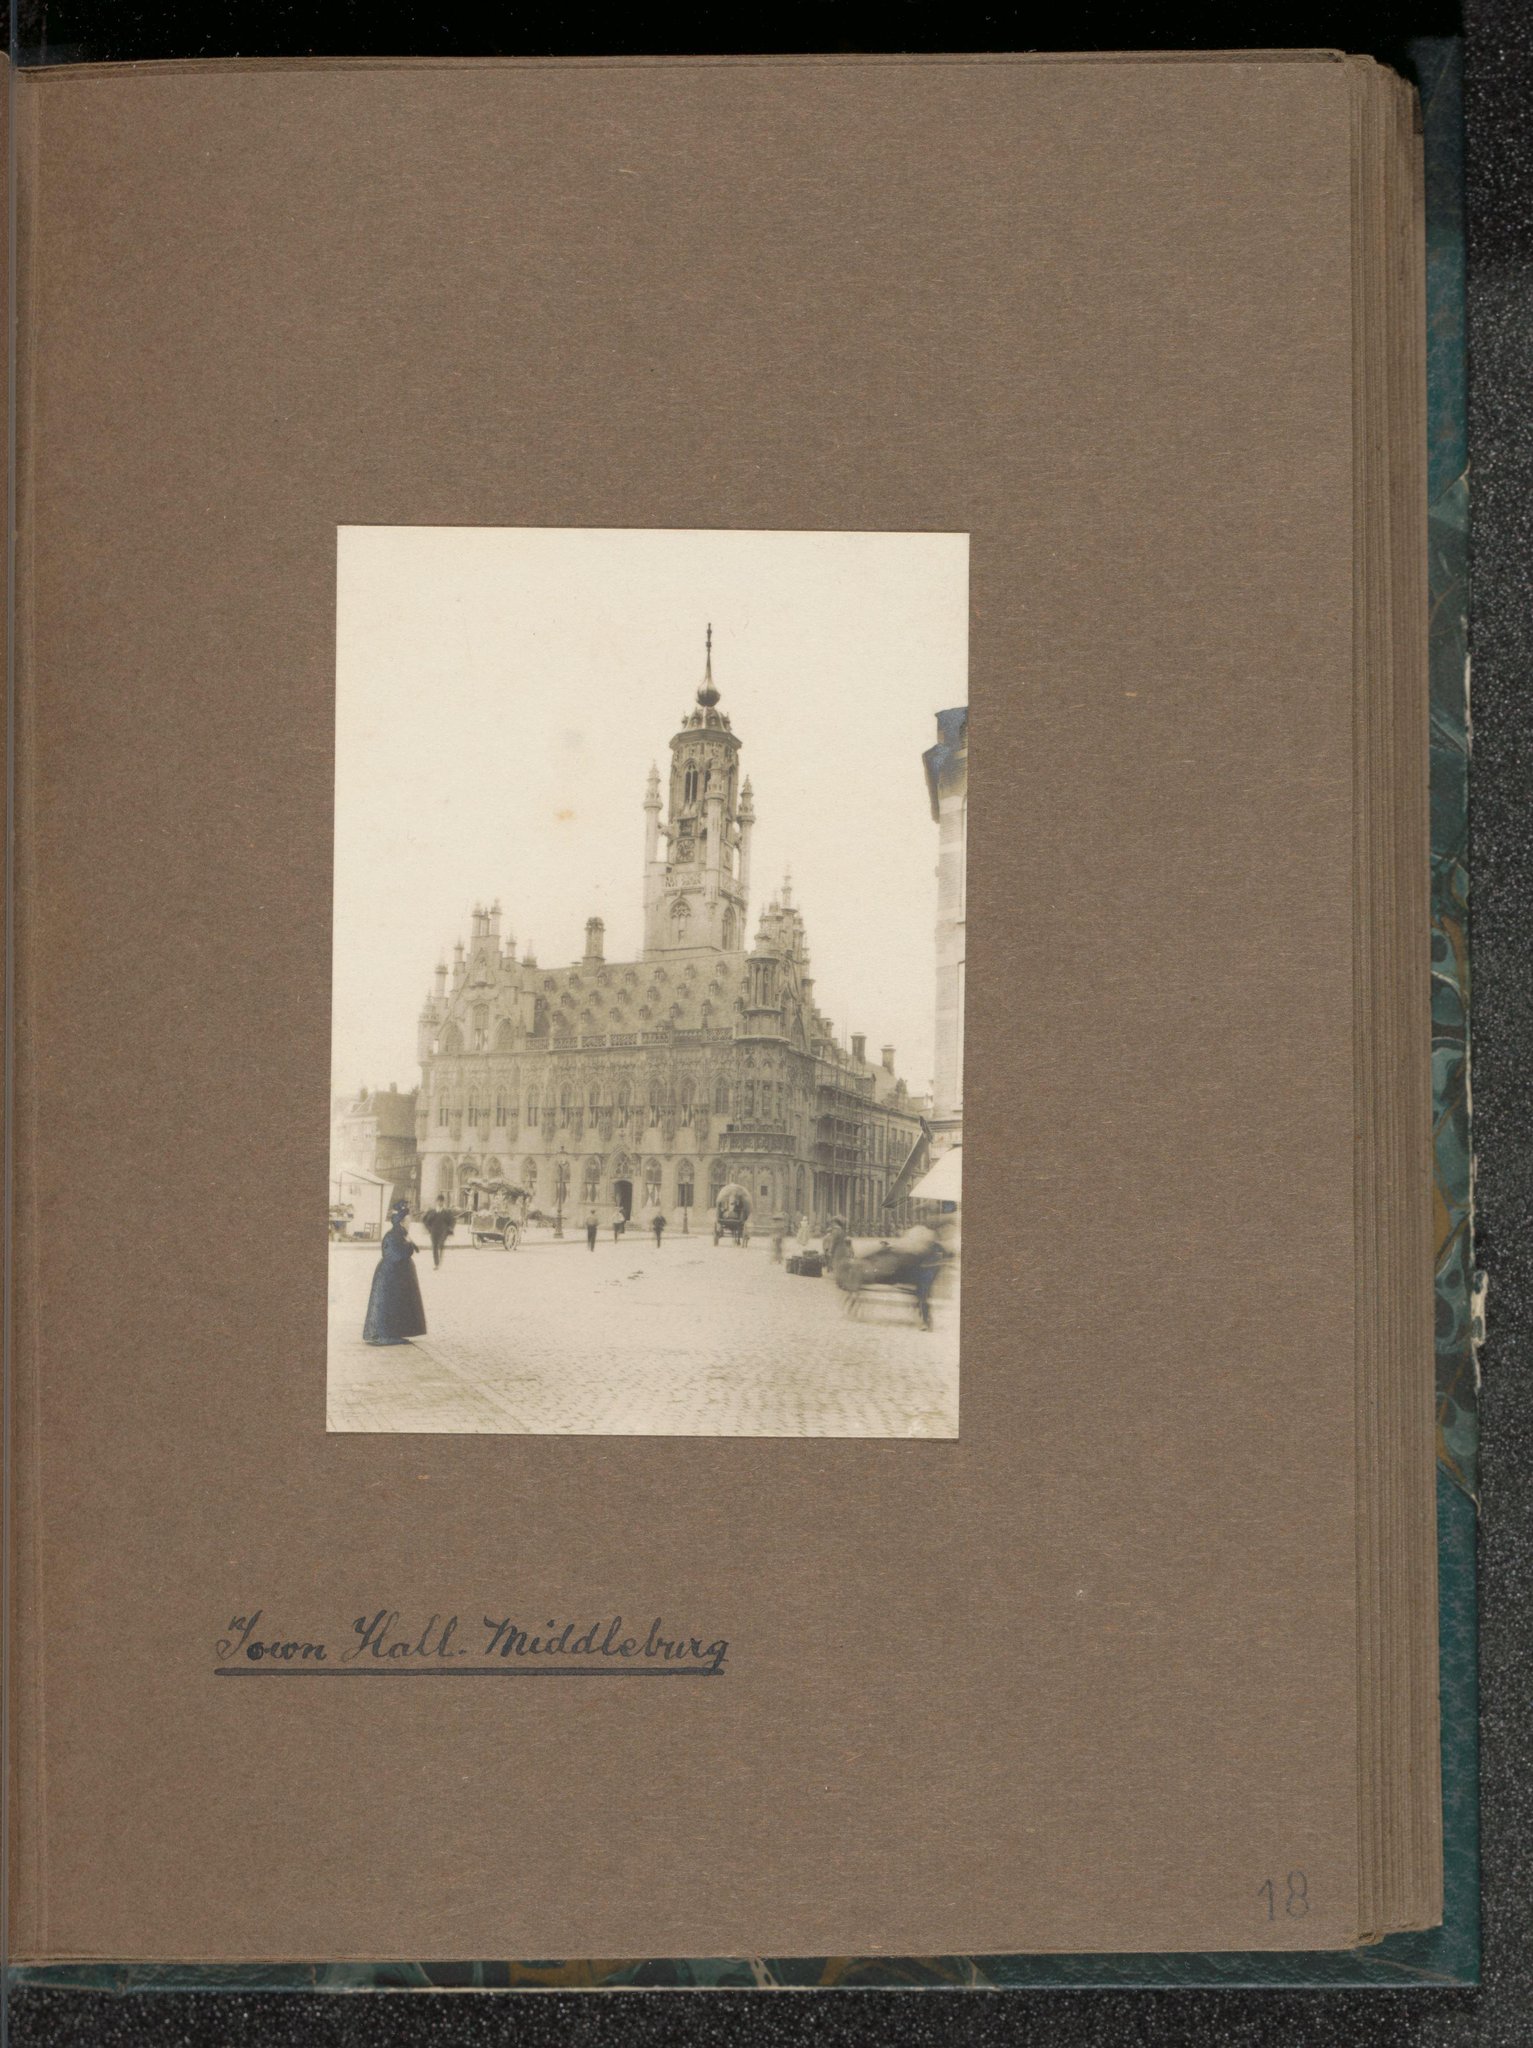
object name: photograph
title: Town Hall Middleburg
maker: Anonymous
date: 1912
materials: photographic support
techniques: gelatin silver print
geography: middelburg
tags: tower, clock tower ~ monumental adornment, townhall, travelling; tourism, square, place, circus, etc. (+ city(-scape) with figures, staffage), middelburg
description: Onderdeel van Fotoalbum van de excursie naar Nederland van de Britse amateurfotografenvereniging P.C.U.K.